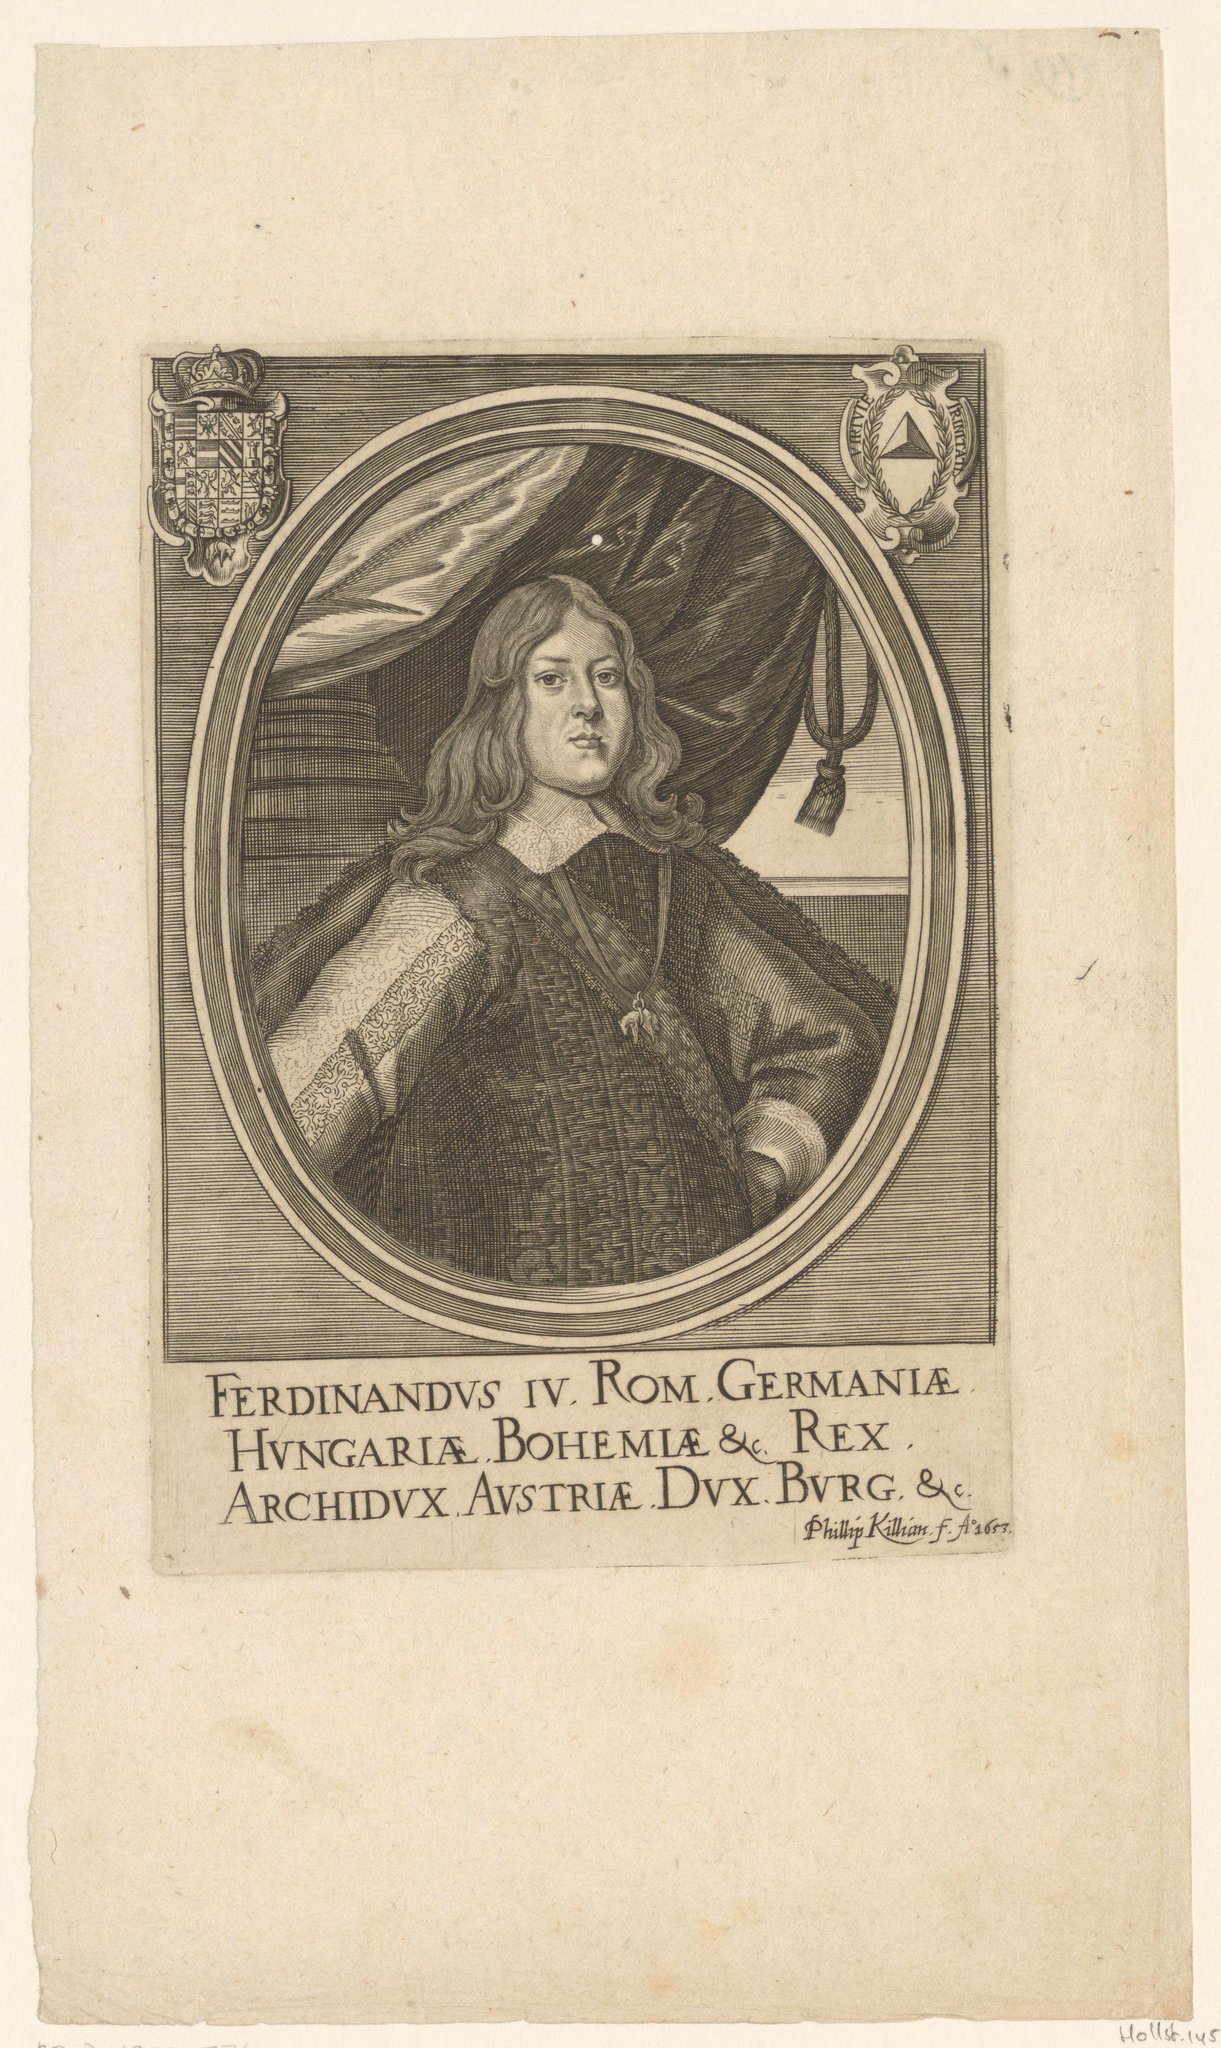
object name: print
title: Portret van Ferdinand IV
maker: philipp kilian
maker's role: print maker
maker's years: 1628-1693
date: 1653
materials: paper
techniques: engraving, etching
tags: historical persons, king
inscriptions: collector's mark: Lugt 2228, collector's mark: Lugt 2228